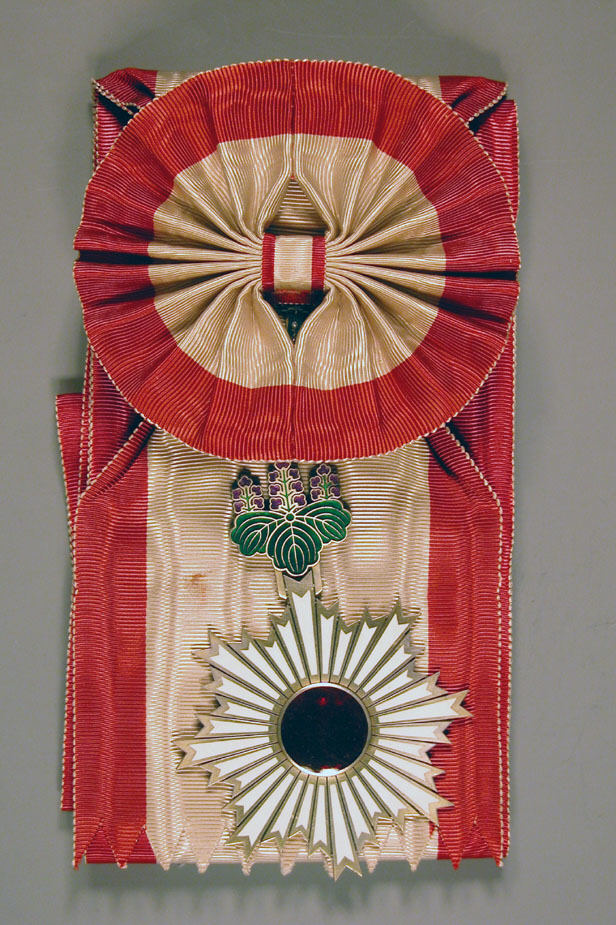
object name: insignia, medal and button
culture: japanese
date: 1867-1900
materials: ribbon